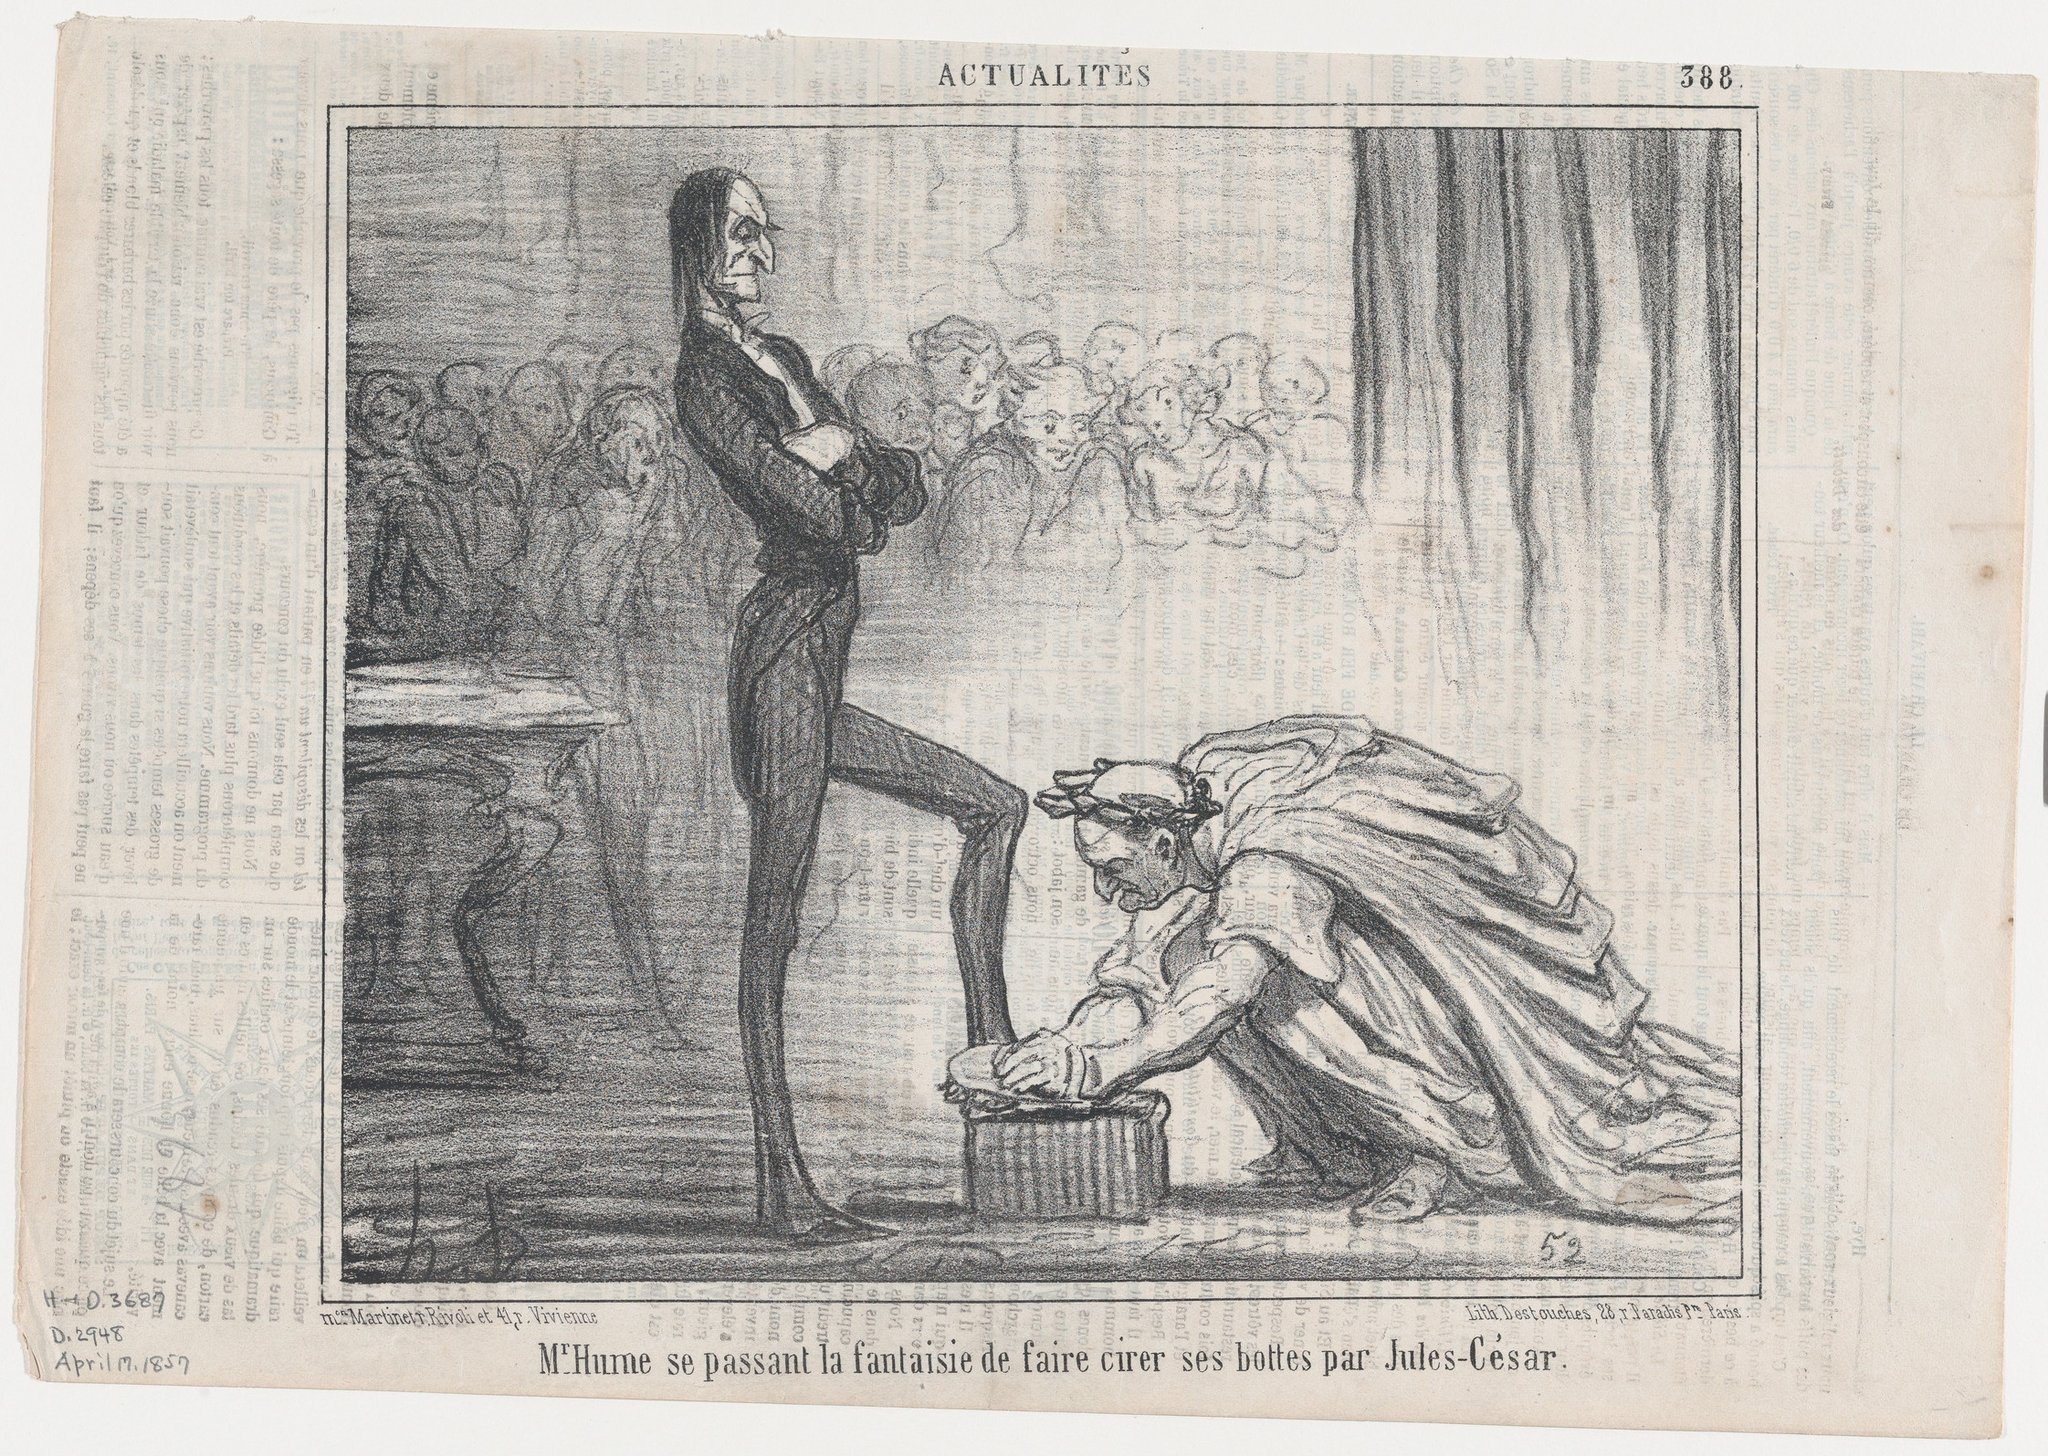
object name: print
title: Mr. Hume se passant la fantaisie..., from Actualités, published in Le Charivari, April 17, 1857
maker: honoré daumier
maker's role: artist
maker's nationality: french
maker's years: 1808-1879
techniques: lithograph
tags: men,crowd